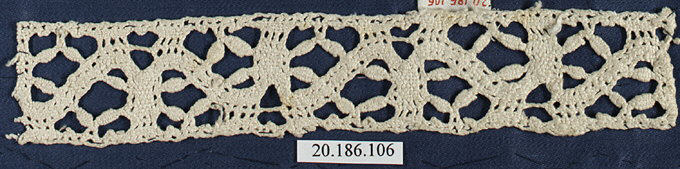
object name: insertion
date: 1601-1700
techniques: lace